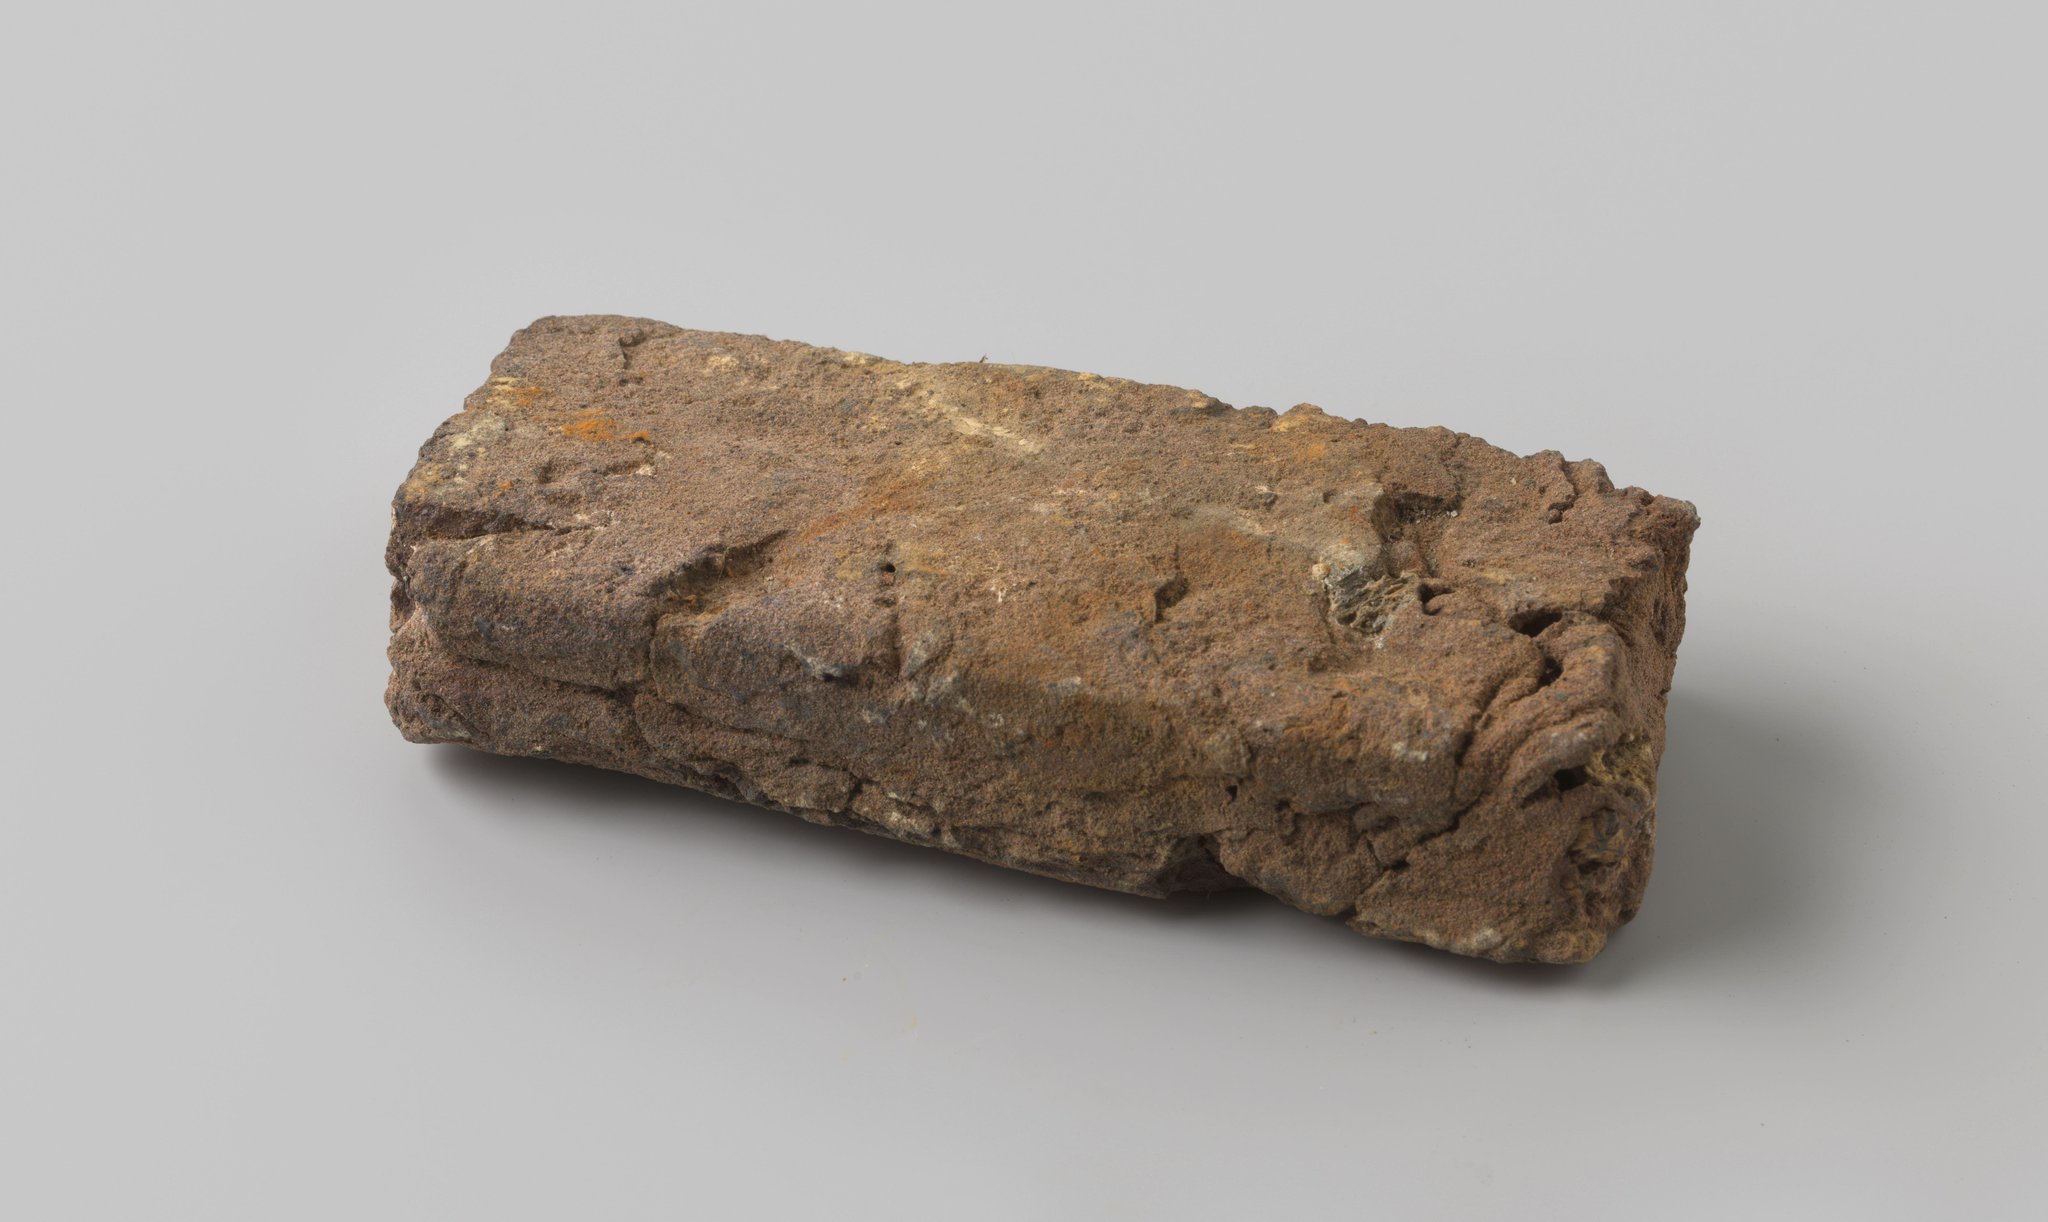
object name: brick clay product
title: Baksteen uit het wrak van de Oost-Indiëvaarder Hollandia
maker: Anonymous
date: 1700-1743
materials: brick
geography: netherlands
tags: verenigde oostindische compagnie, hollandia (schip), annet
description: Constructional elements, brick; sim. 80H2567, sim. 80H1208, sim. 80H1009.